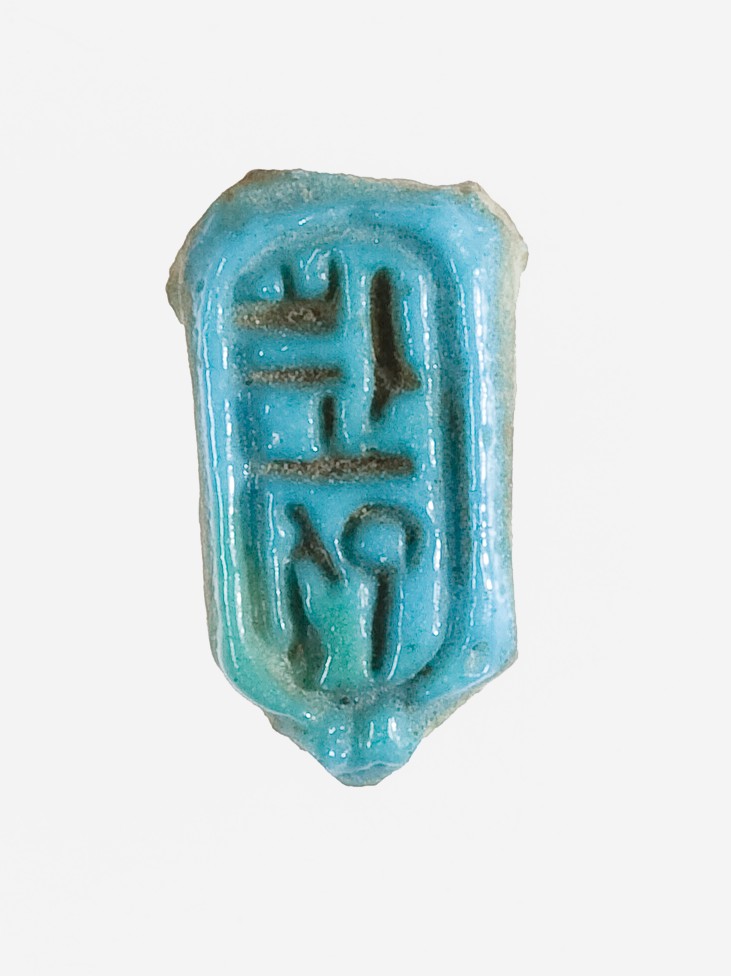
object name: amulet, cartouche, amenhotep iii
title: Amulet: Cartouche of Amenhotep III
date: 1390-1352 BCE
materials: faience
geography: egypt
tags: hieroglyphs